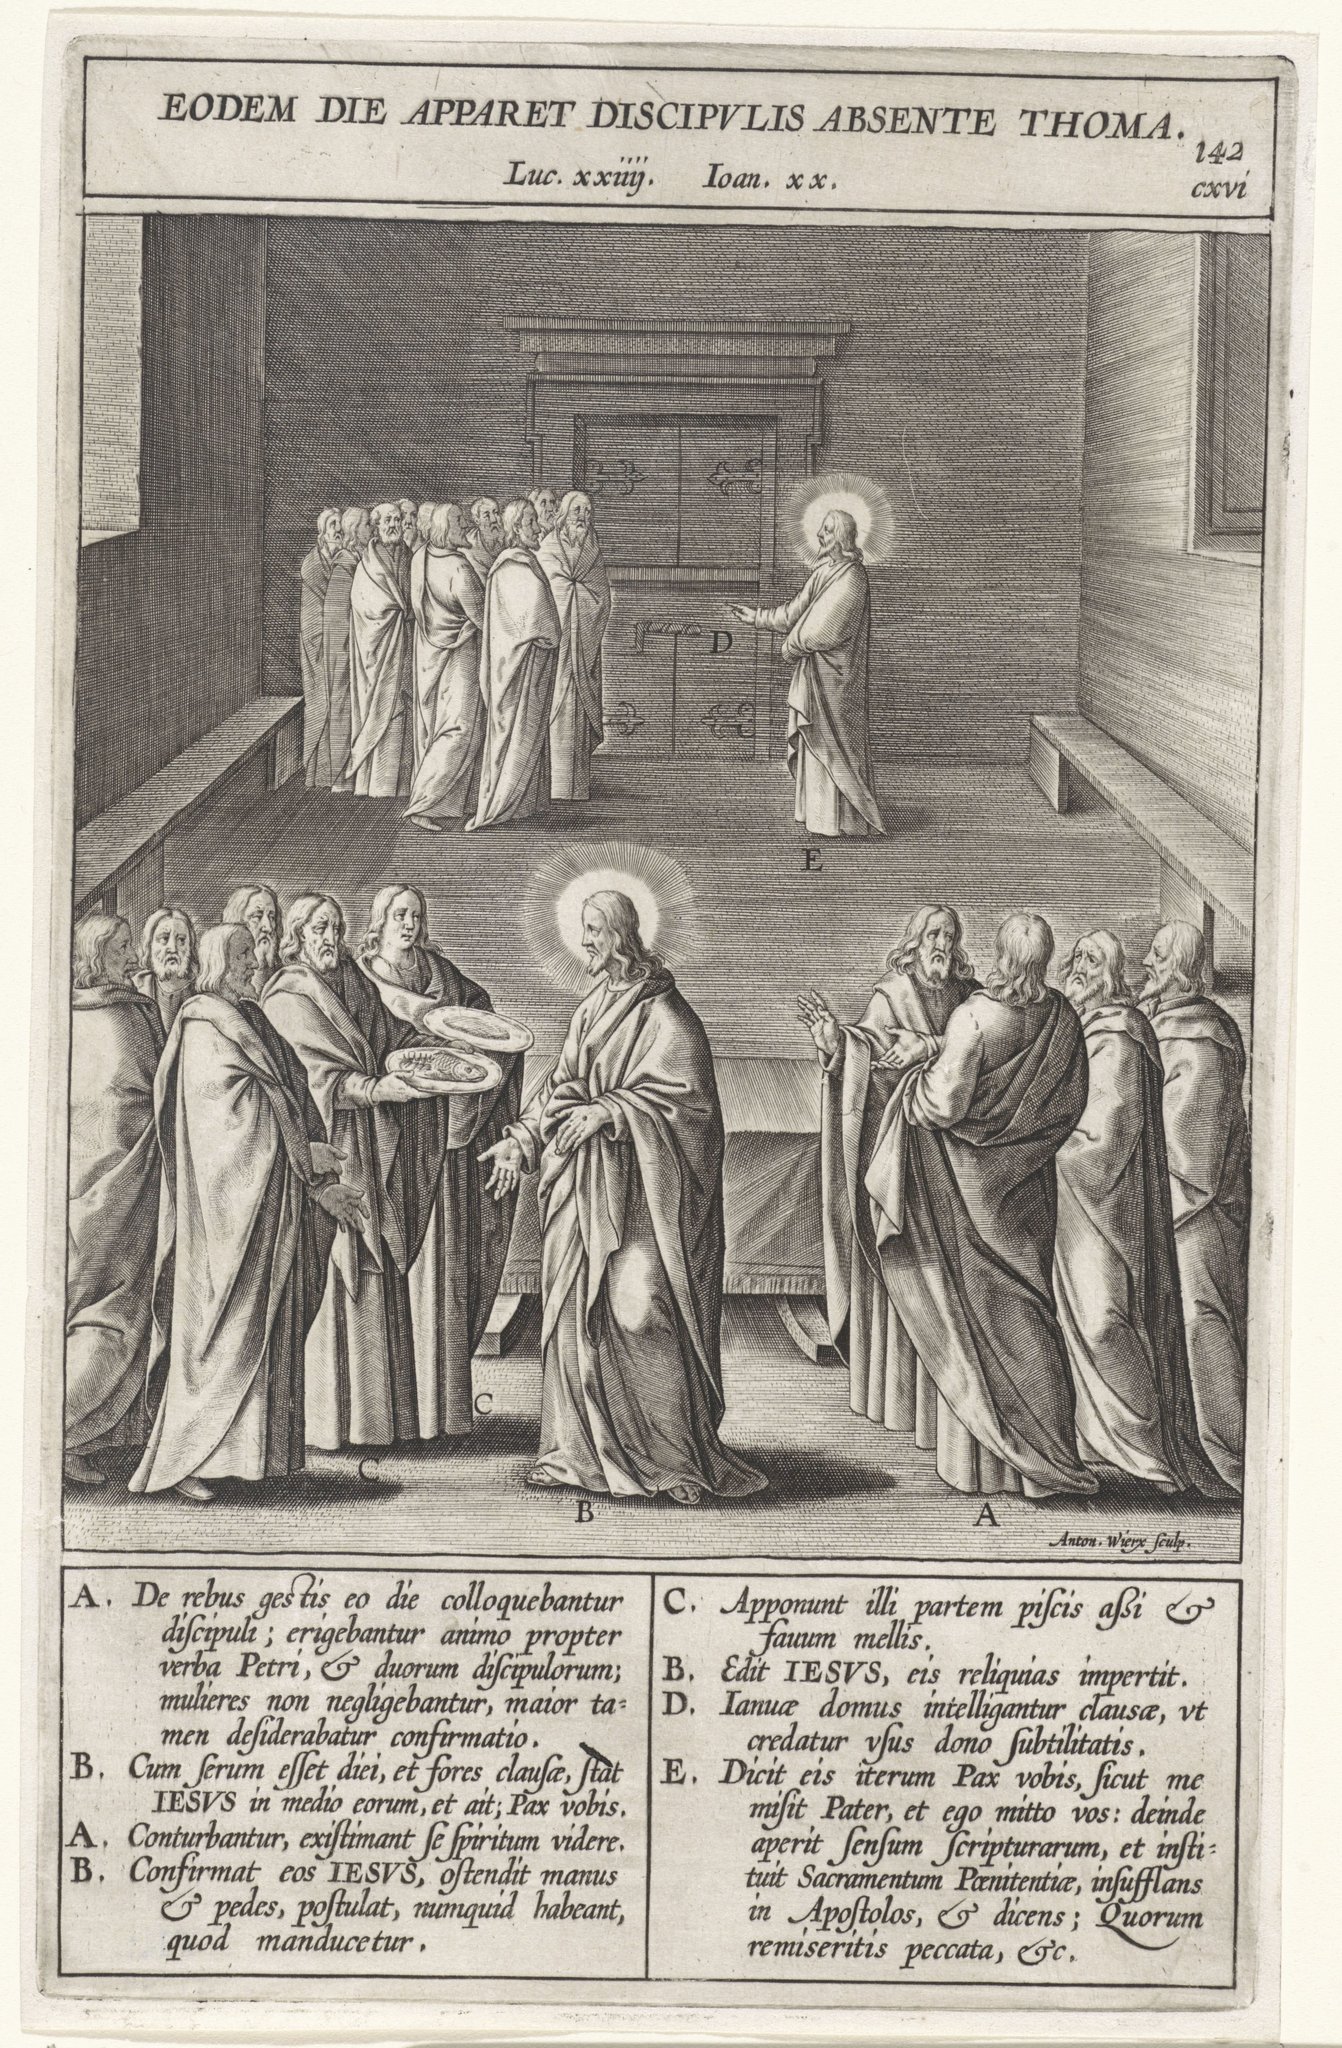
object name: print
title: Eodem Die Apparet Discipvlis Absente Thoma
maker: antonie wierix (ii)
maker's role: draughtsman, print maker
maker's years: 1555-1604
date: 1593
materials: paper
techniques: engraving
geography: antwerp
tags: christ appears to the apostles (gathered behind locked doors)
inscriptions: collector's mark: Lugt 2165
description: In Jeruzalem verschijnt Christus aan de twaalf apostelen. Hij toont hen zijn handen en voeten. De apostelen zijn verbijsterd en bieden hem een stuk geroosterde vis te eten aan. Bij verschillende elementen uit de voorstelling staan letters die corresponderen met de legenda in de marge.